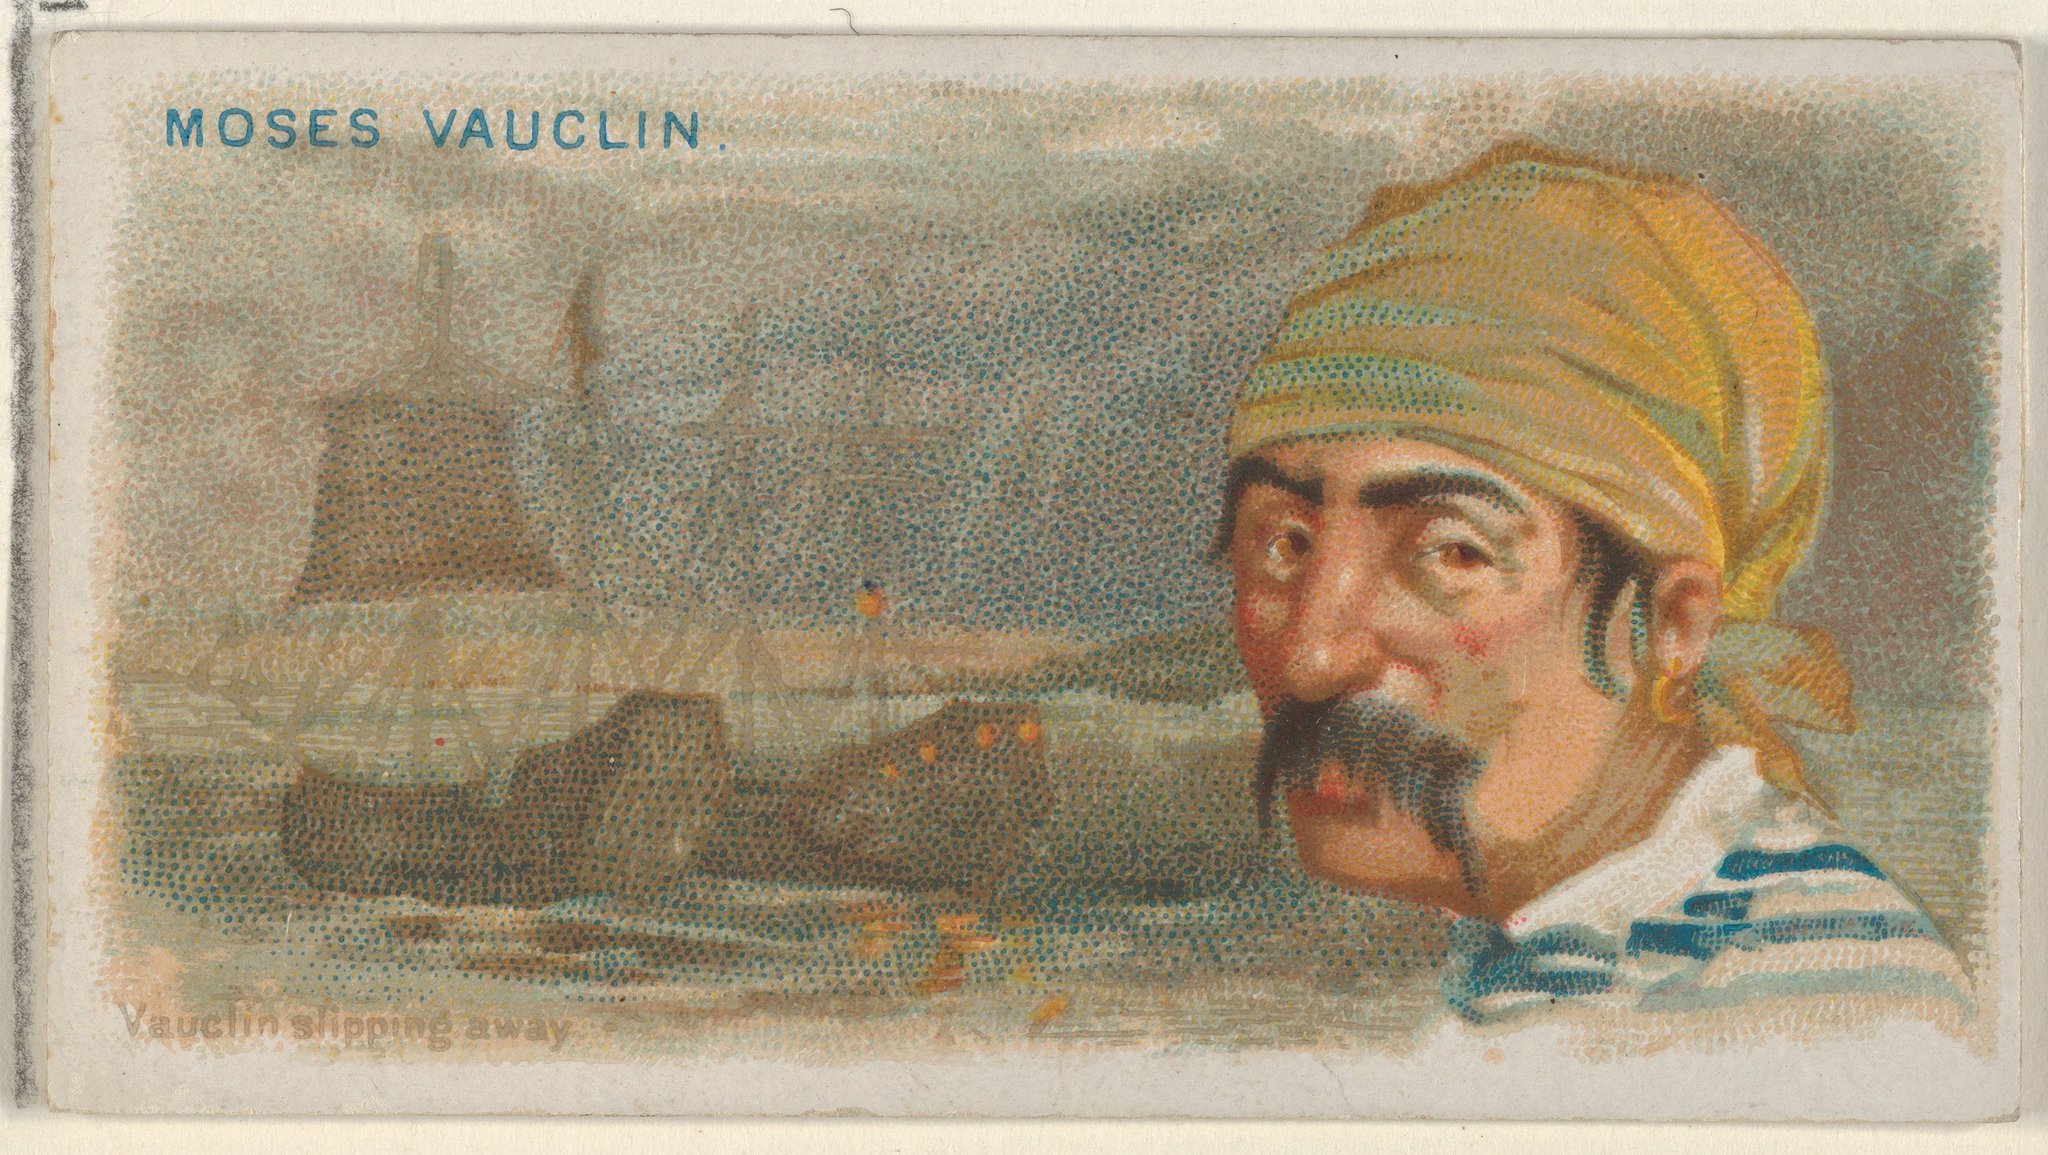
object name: print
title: Moise Vauquelin, Vauquelin Slipping Away, from the Pirates of the Spanish Main series (N19) for Allen & Ginter Cigarettes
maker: allen & ginter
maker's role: publisher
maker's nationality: american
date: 1888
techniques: color lithograph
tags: men,boats